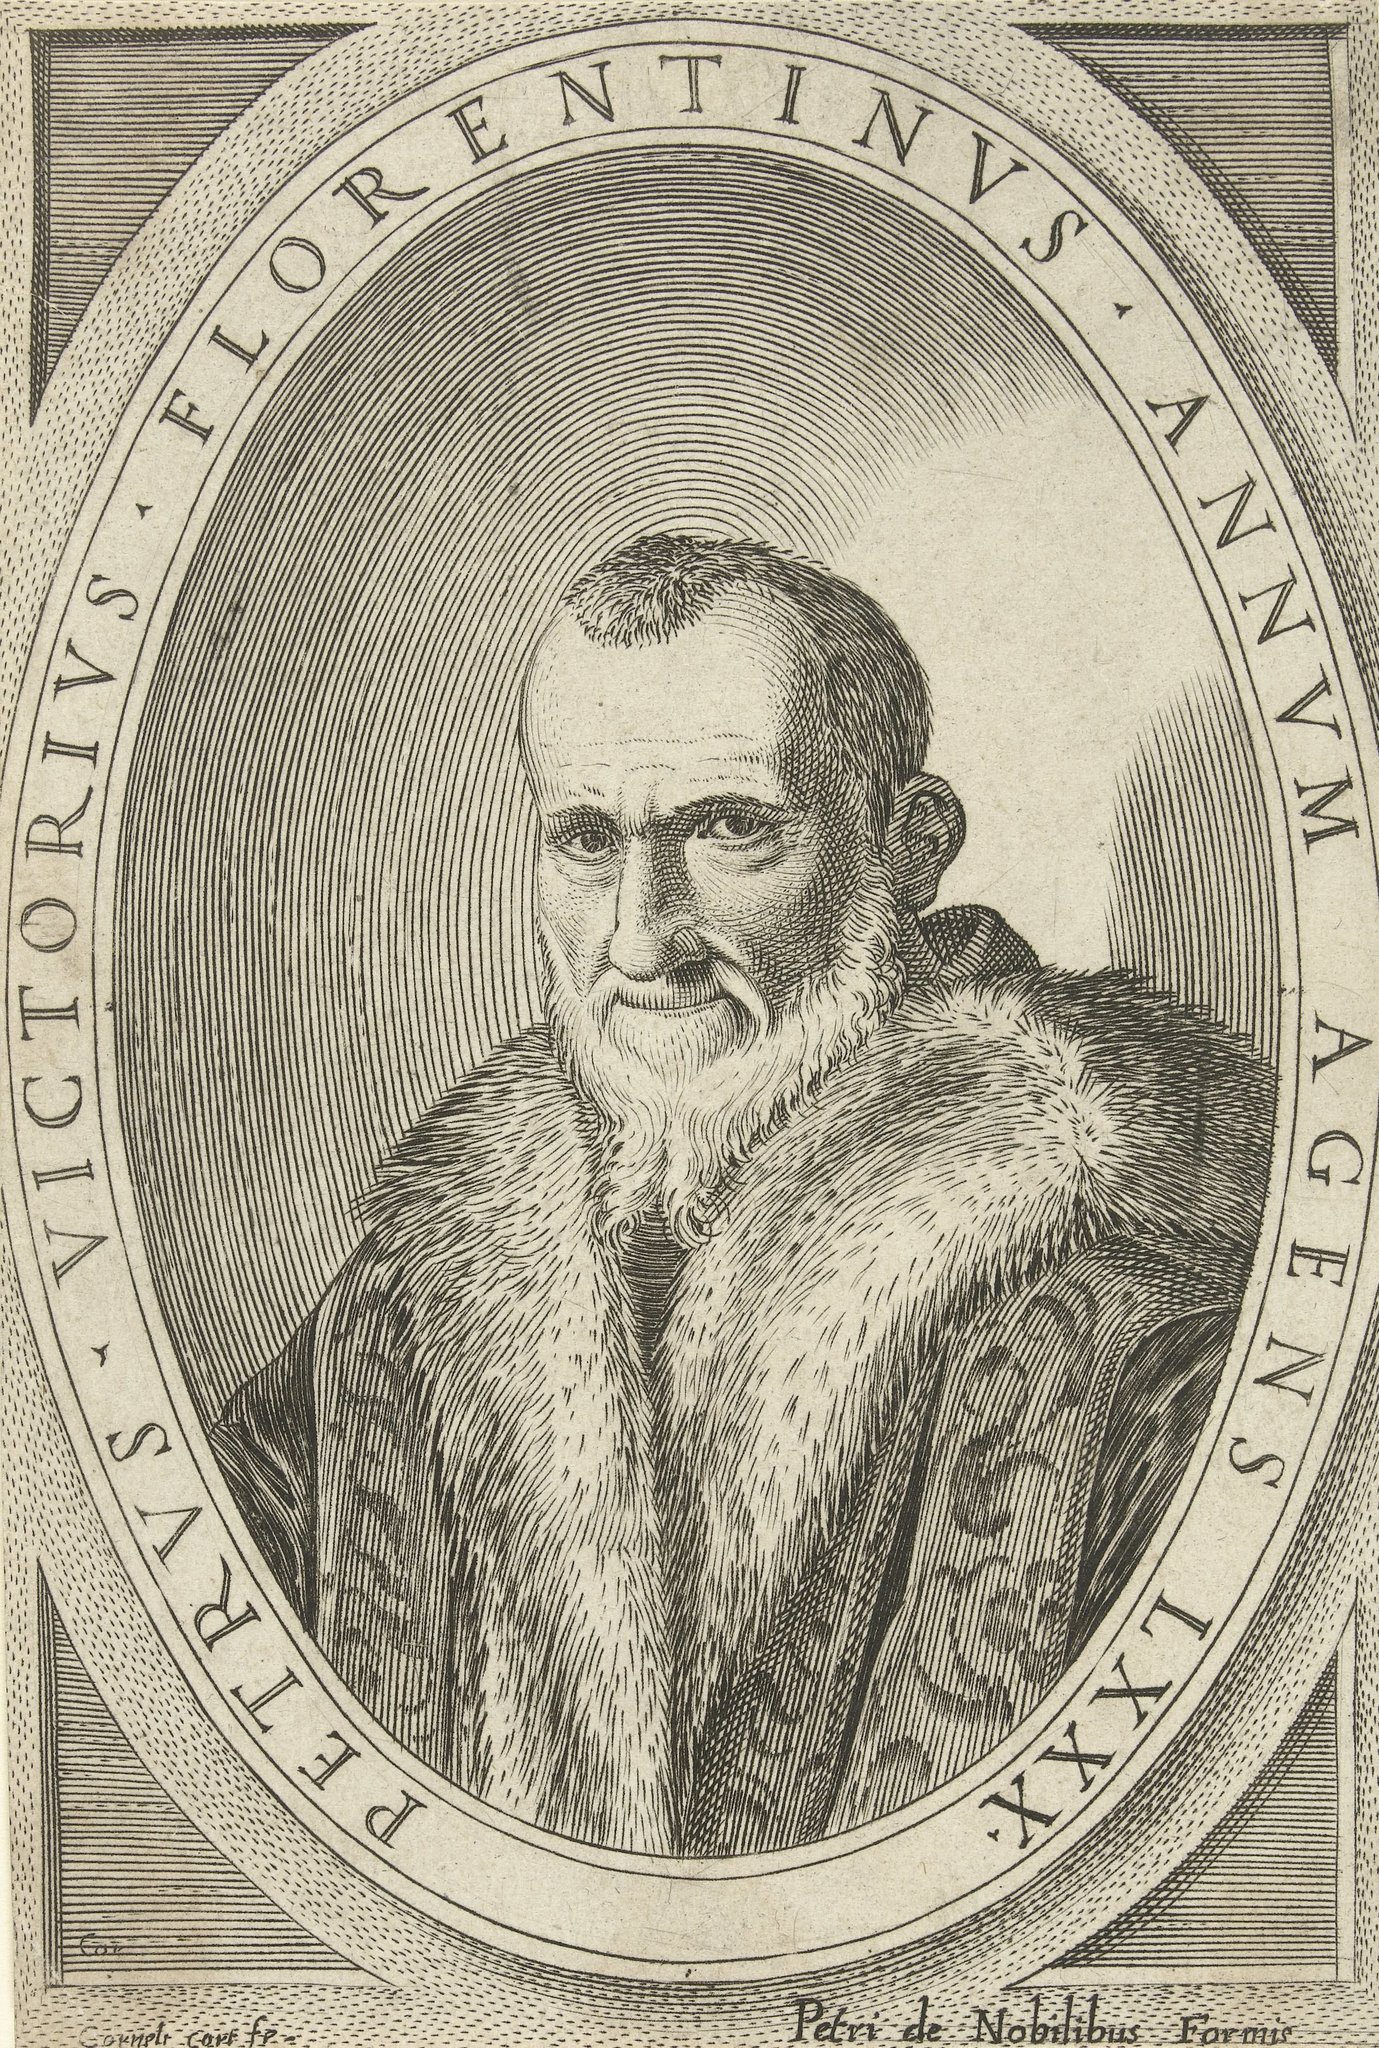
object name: print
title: Portret van Pietro Vettori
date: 1584-1585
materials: paper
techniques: engraving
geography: rome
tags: schrijver, filoloog, piero vettòri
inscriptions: collector's mark: Lugt 2228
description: Portret van Pietro Vettori op 80-jarige leeftijd, in ovaal met randschrift.